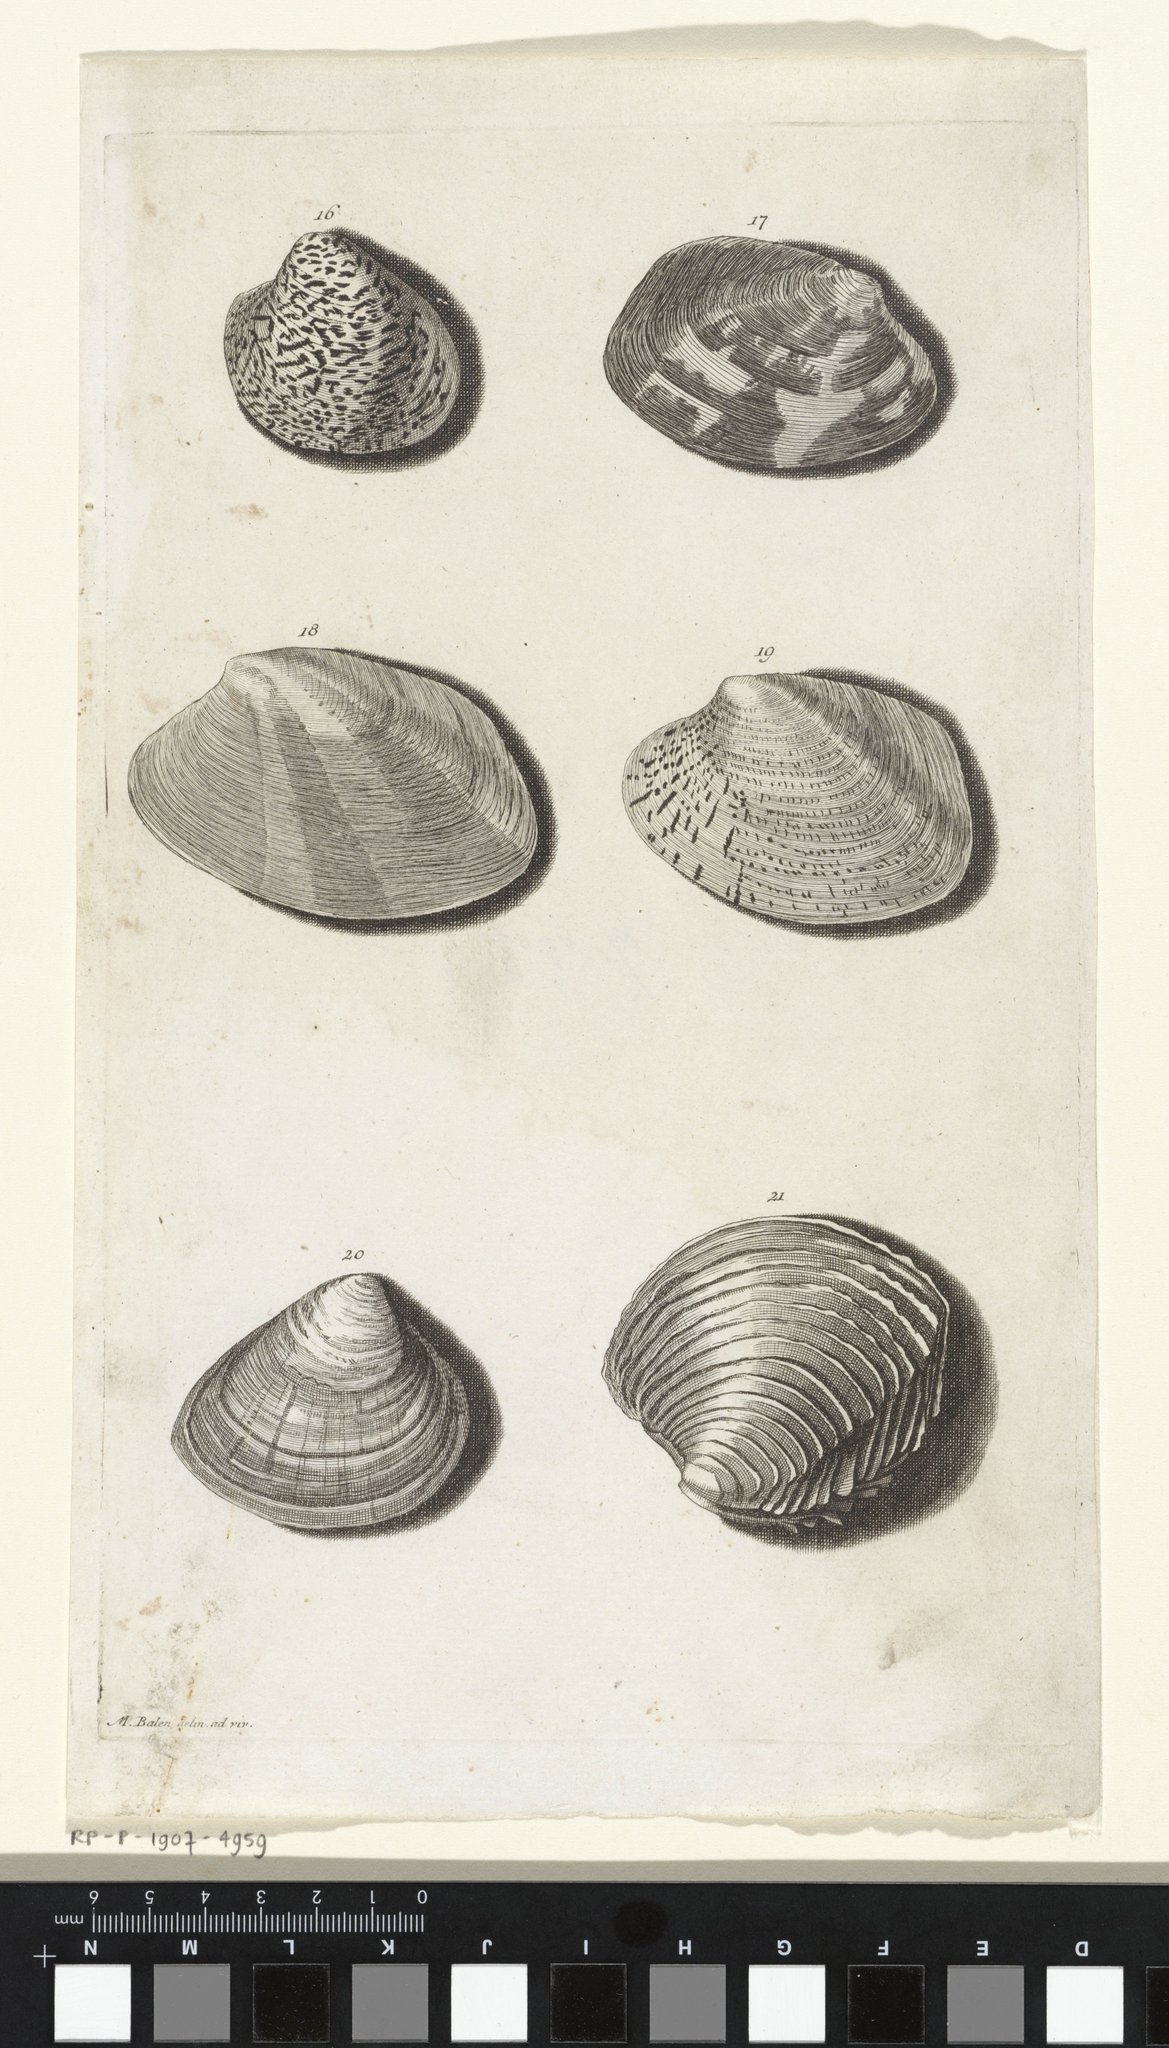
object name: print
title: Zes schelpen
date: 1705-1816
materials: paper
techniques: etching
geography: northern netherlands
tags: molluscs (+ shell, snail-shell etc.)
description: Zes verschillende schelpen. De schelpen zijn genummerd 16-21.